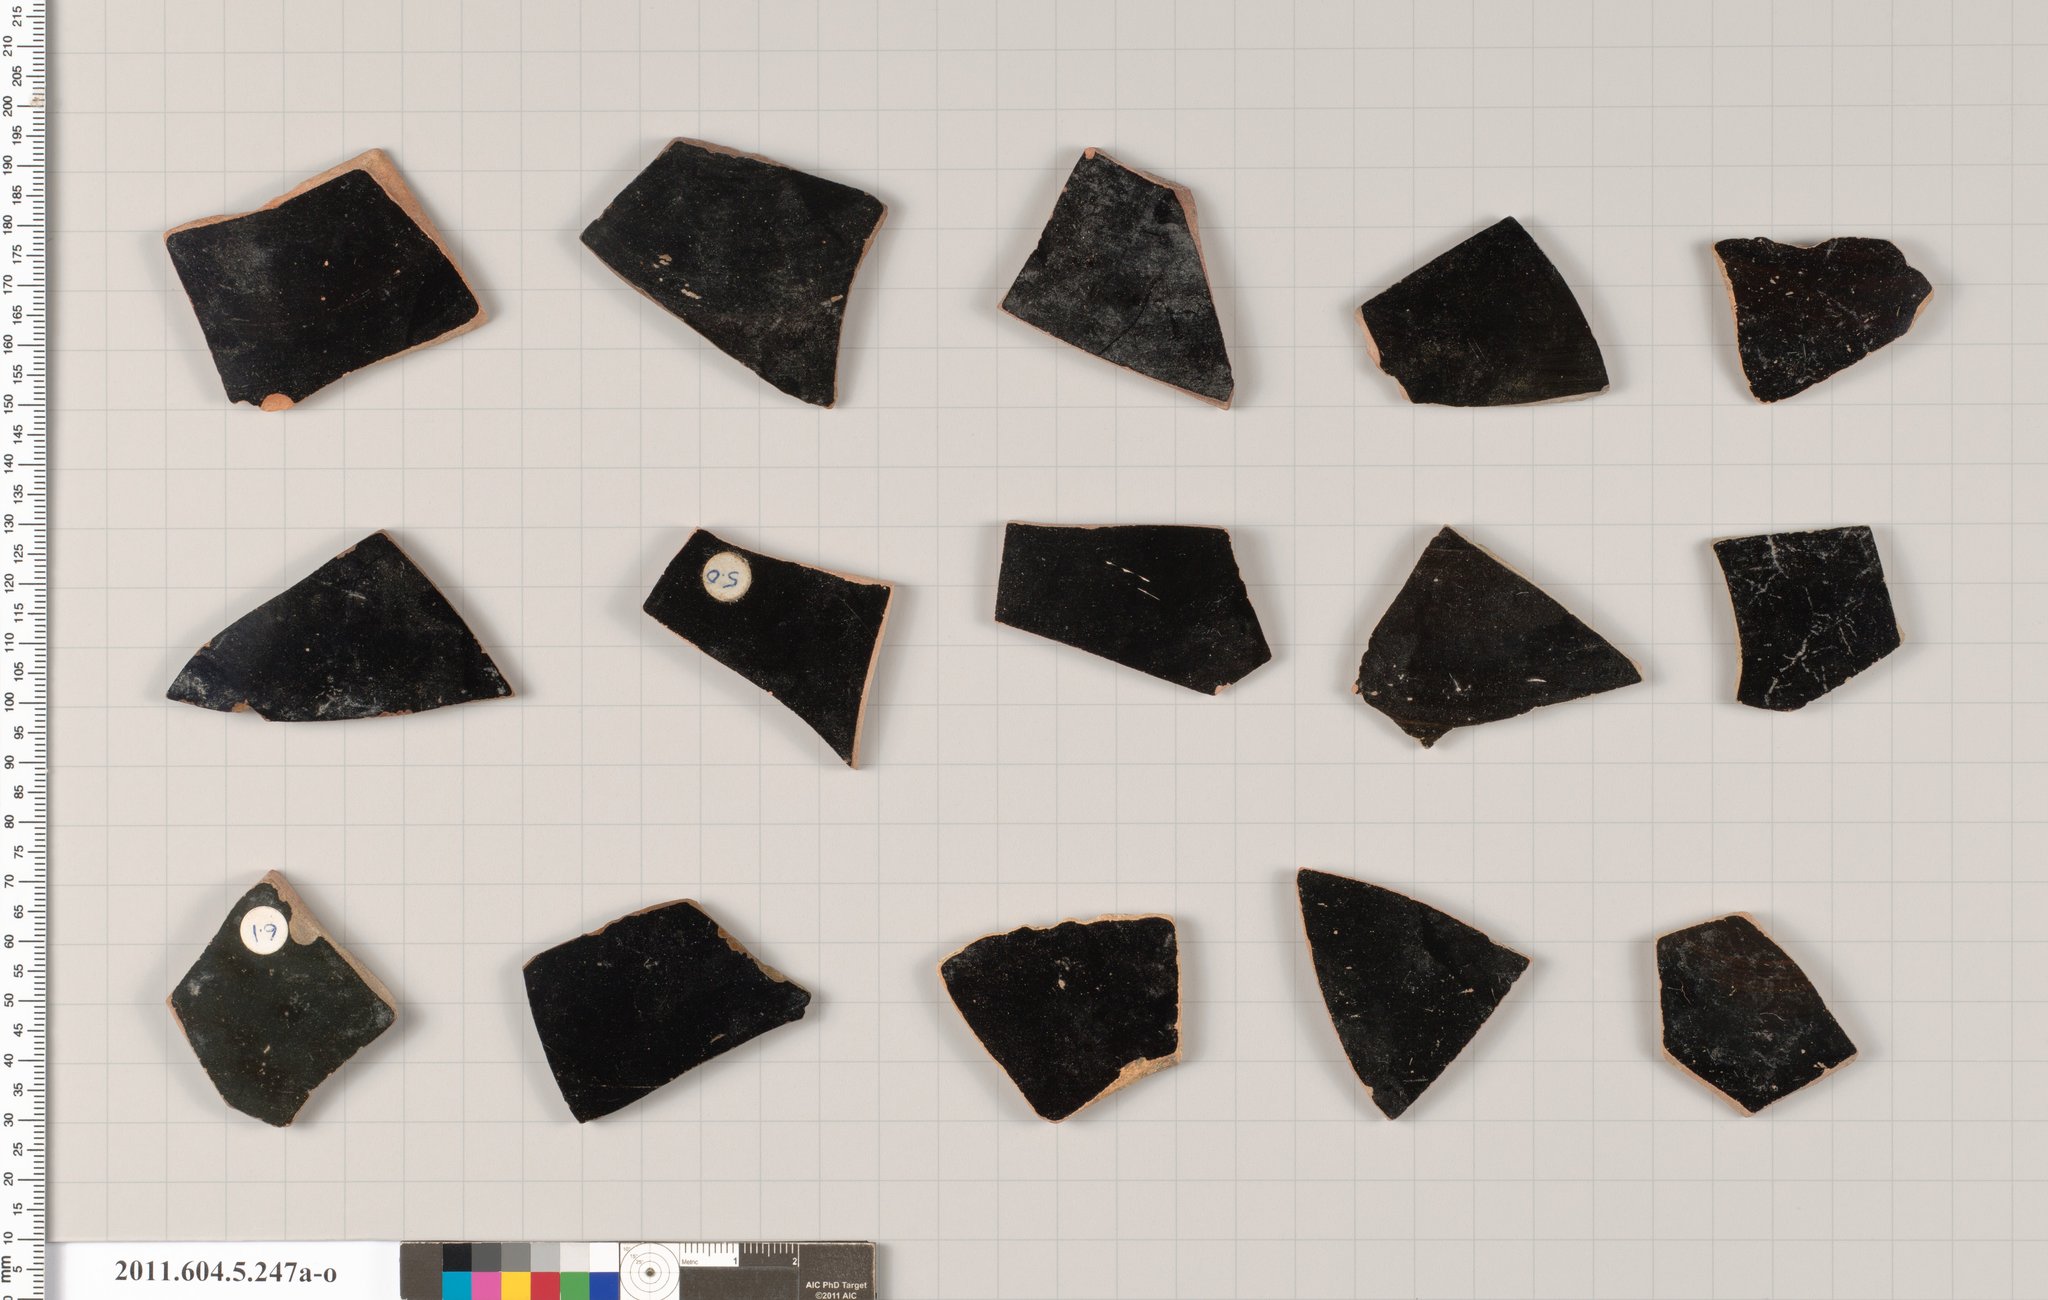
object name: kylix fragment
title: Terracotta fragments of kylikes (drinking cups)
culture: greek, attic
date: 600-401 BCE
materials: terracotta